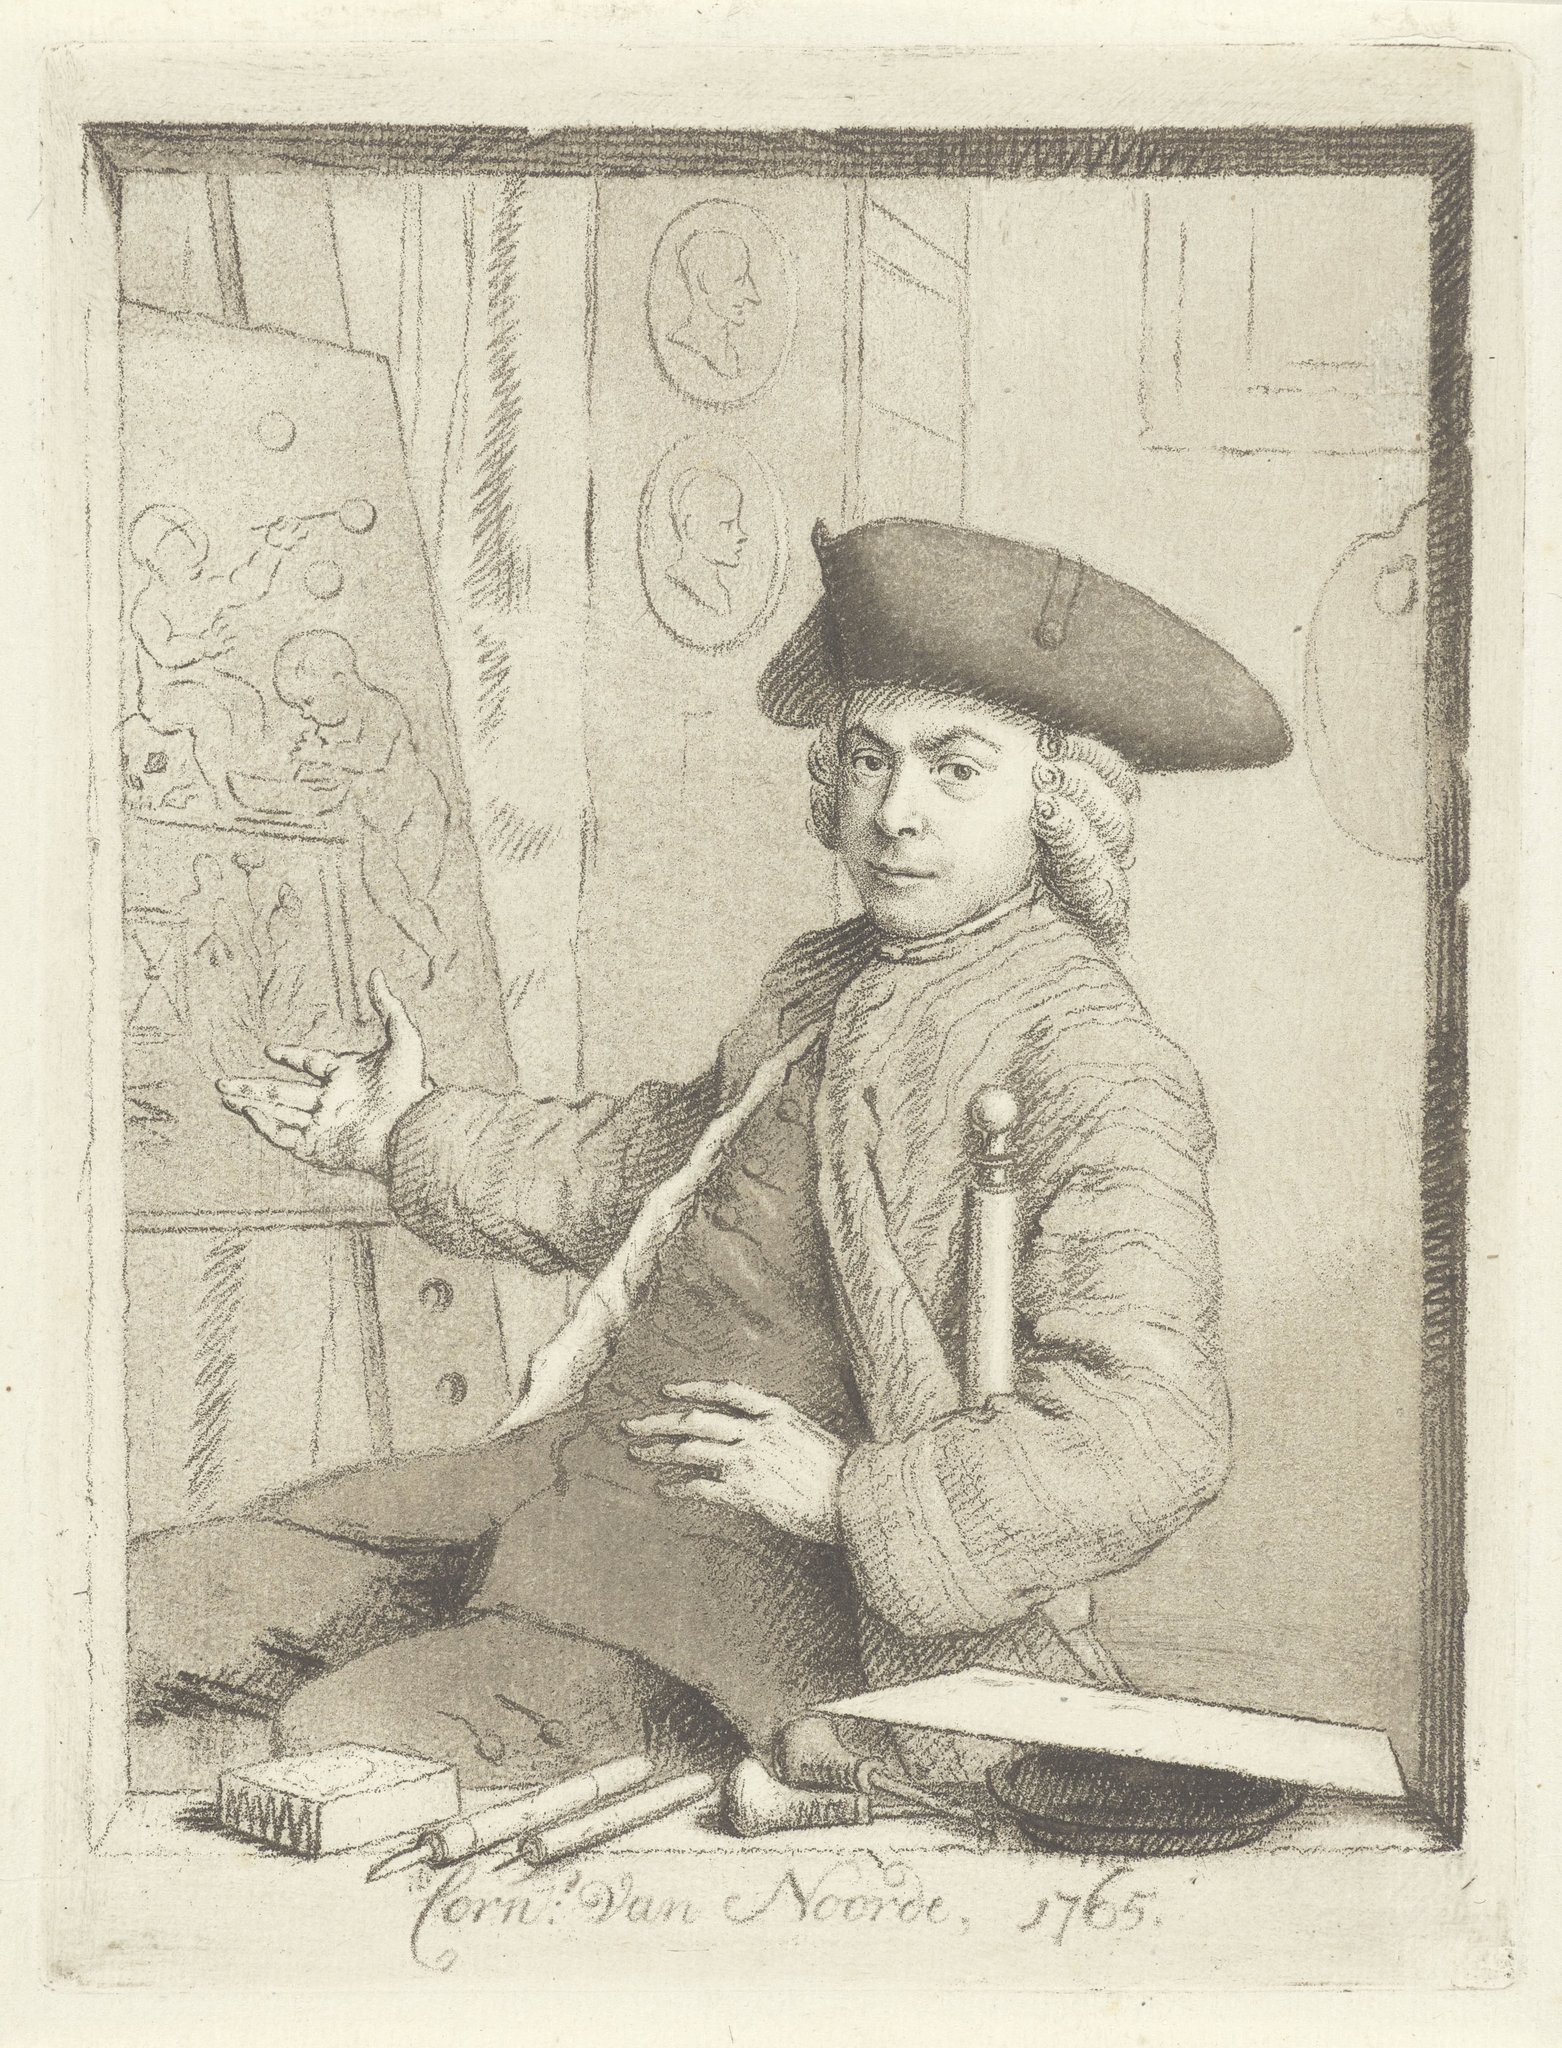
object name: print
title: Zelfportret van Cornelis van Noorde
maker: cornelis van noorde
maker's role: draughtsman, print maker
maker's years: 1731-1795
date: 1765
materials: paper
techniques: printmaking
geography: haarlem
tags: draughtsman, cornelis van noorde, tools, implements of graphic artist, portrait, self-portrait of artist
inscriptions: collector's mark: Lugt 240, inscription: ‘na 't Leeven geteekend en in 't koper gebragt door Corn: van Noorde, 1765.’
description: Zelfportret van Cornelis van Noorde, zittend naast zijn schildersezel, wijzend naar het schilderij dat erop staat. Op de voorgrond liggen de attributen van de graveur.